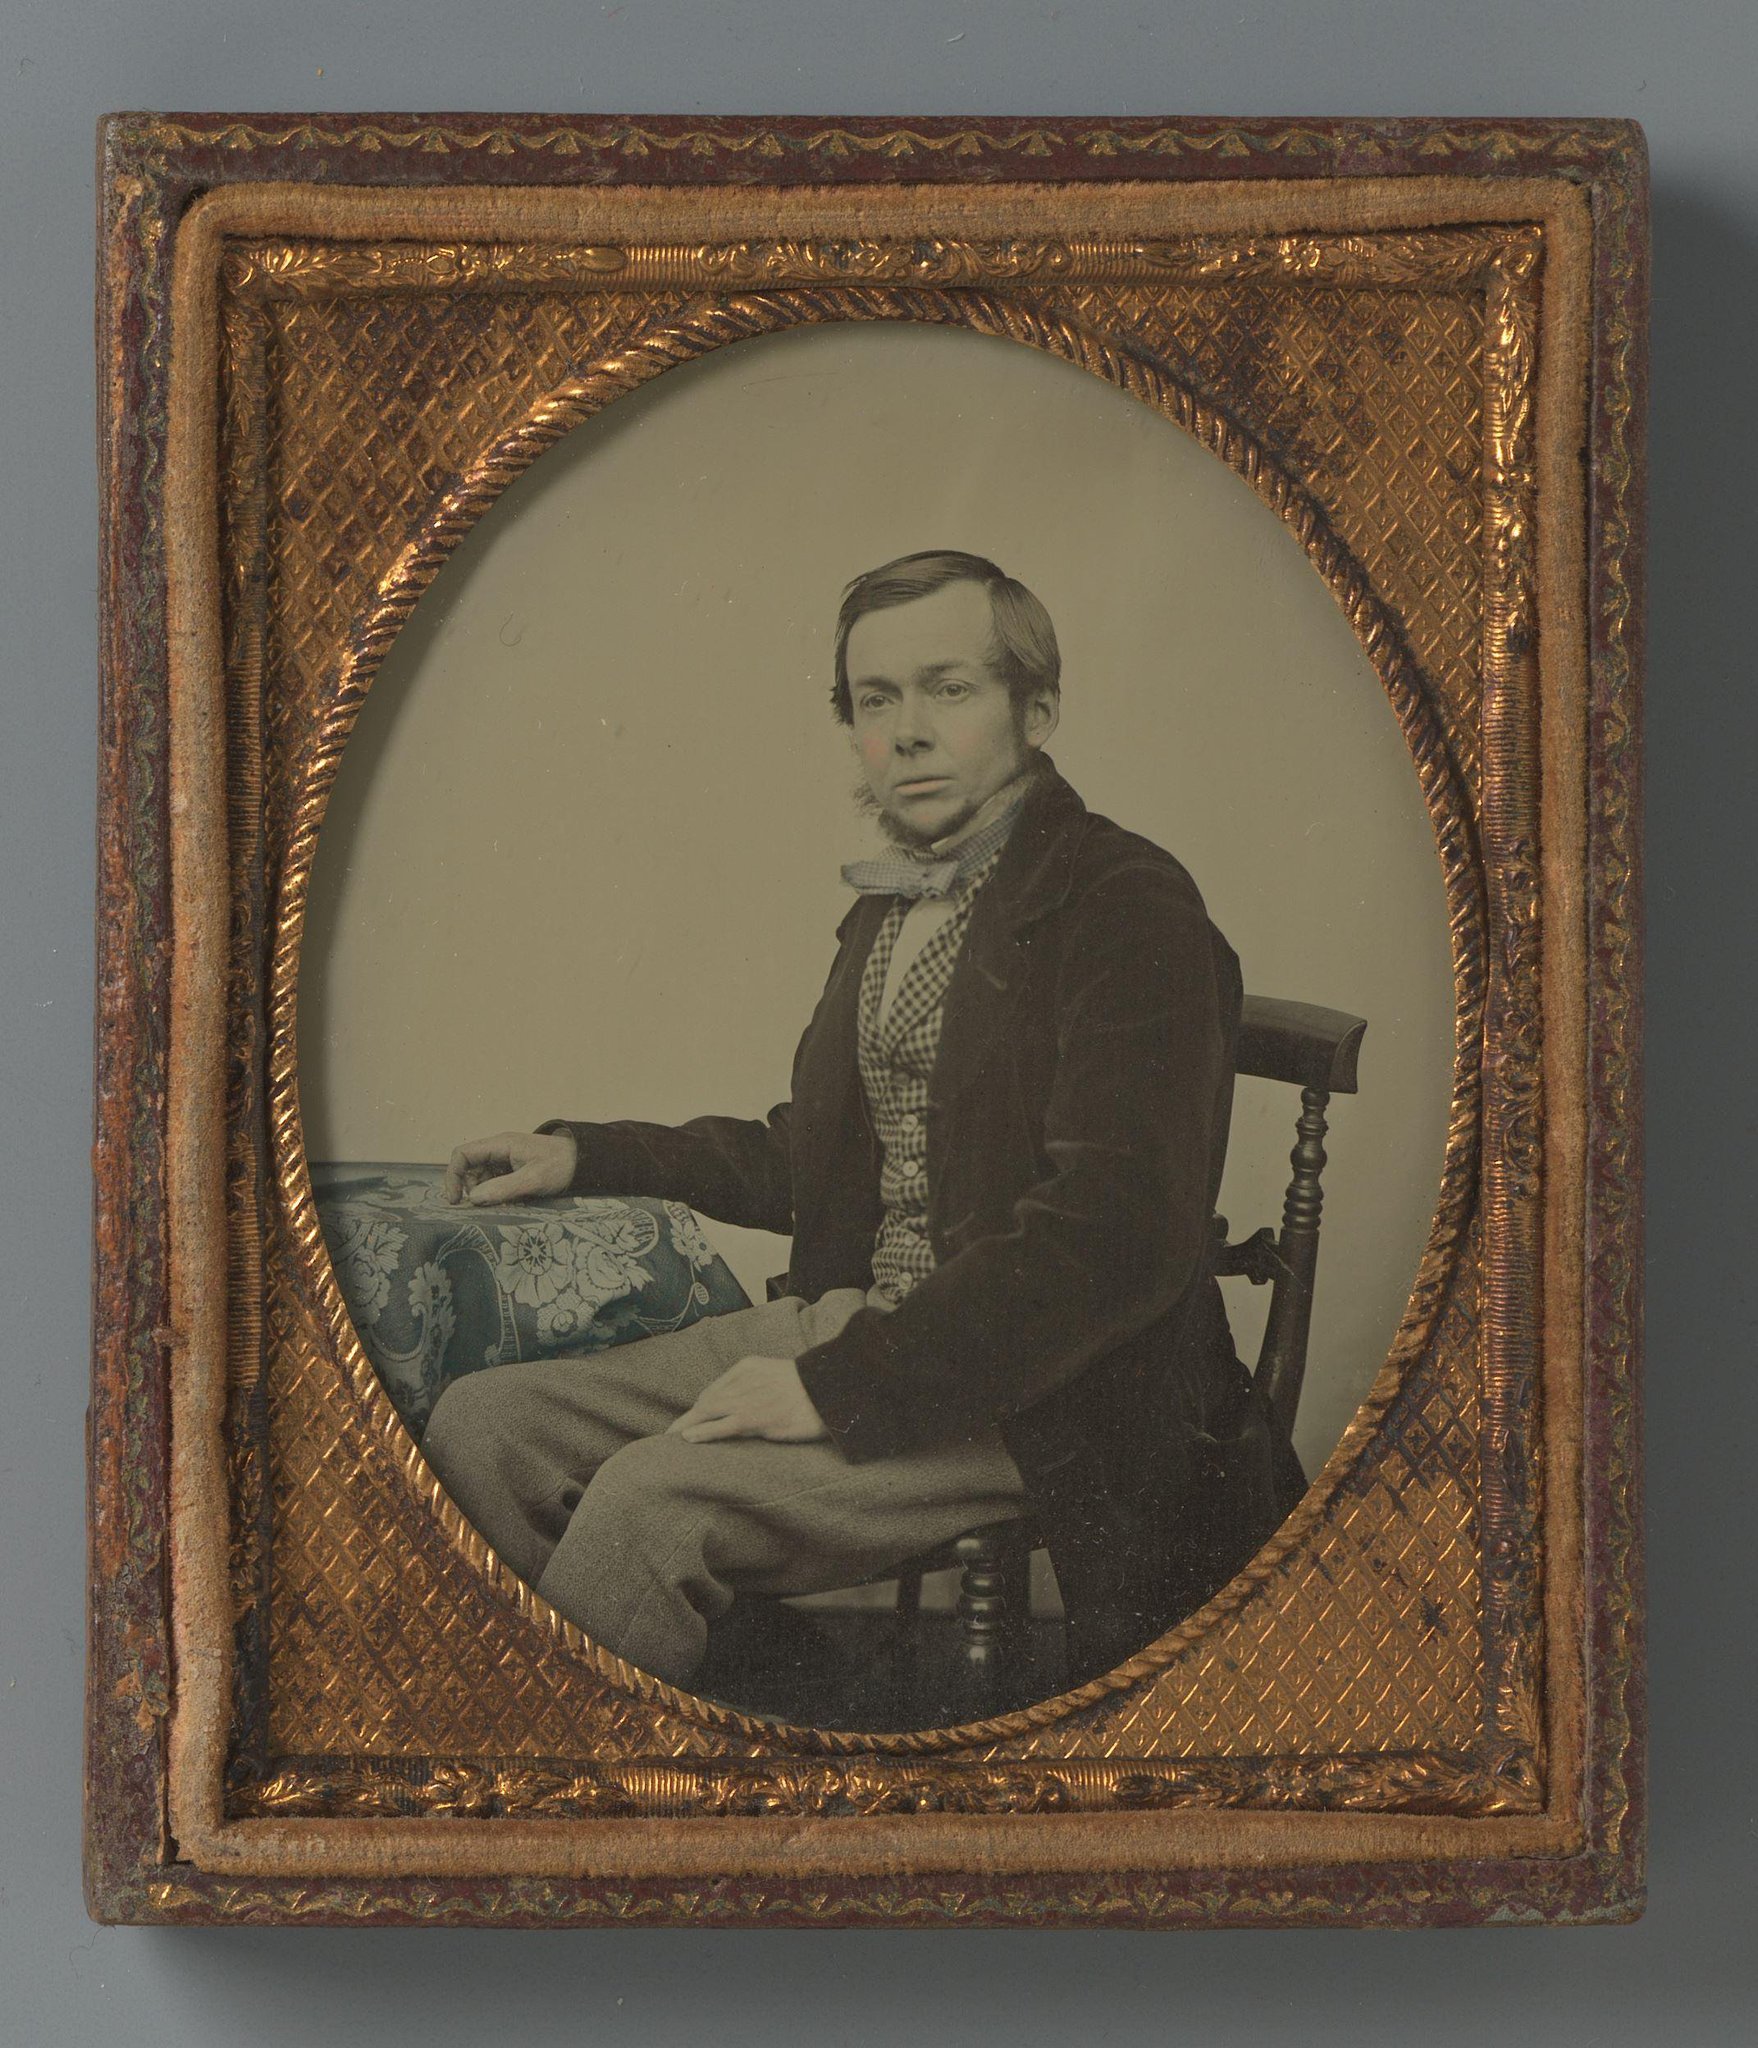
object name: photograph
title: Portret van een onbekende zittende man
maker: Anonymous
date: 1855-1870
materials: glass, metal, paper, velvet, wood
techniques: ambrotype, hand coloring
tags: sitting figure, historical persons